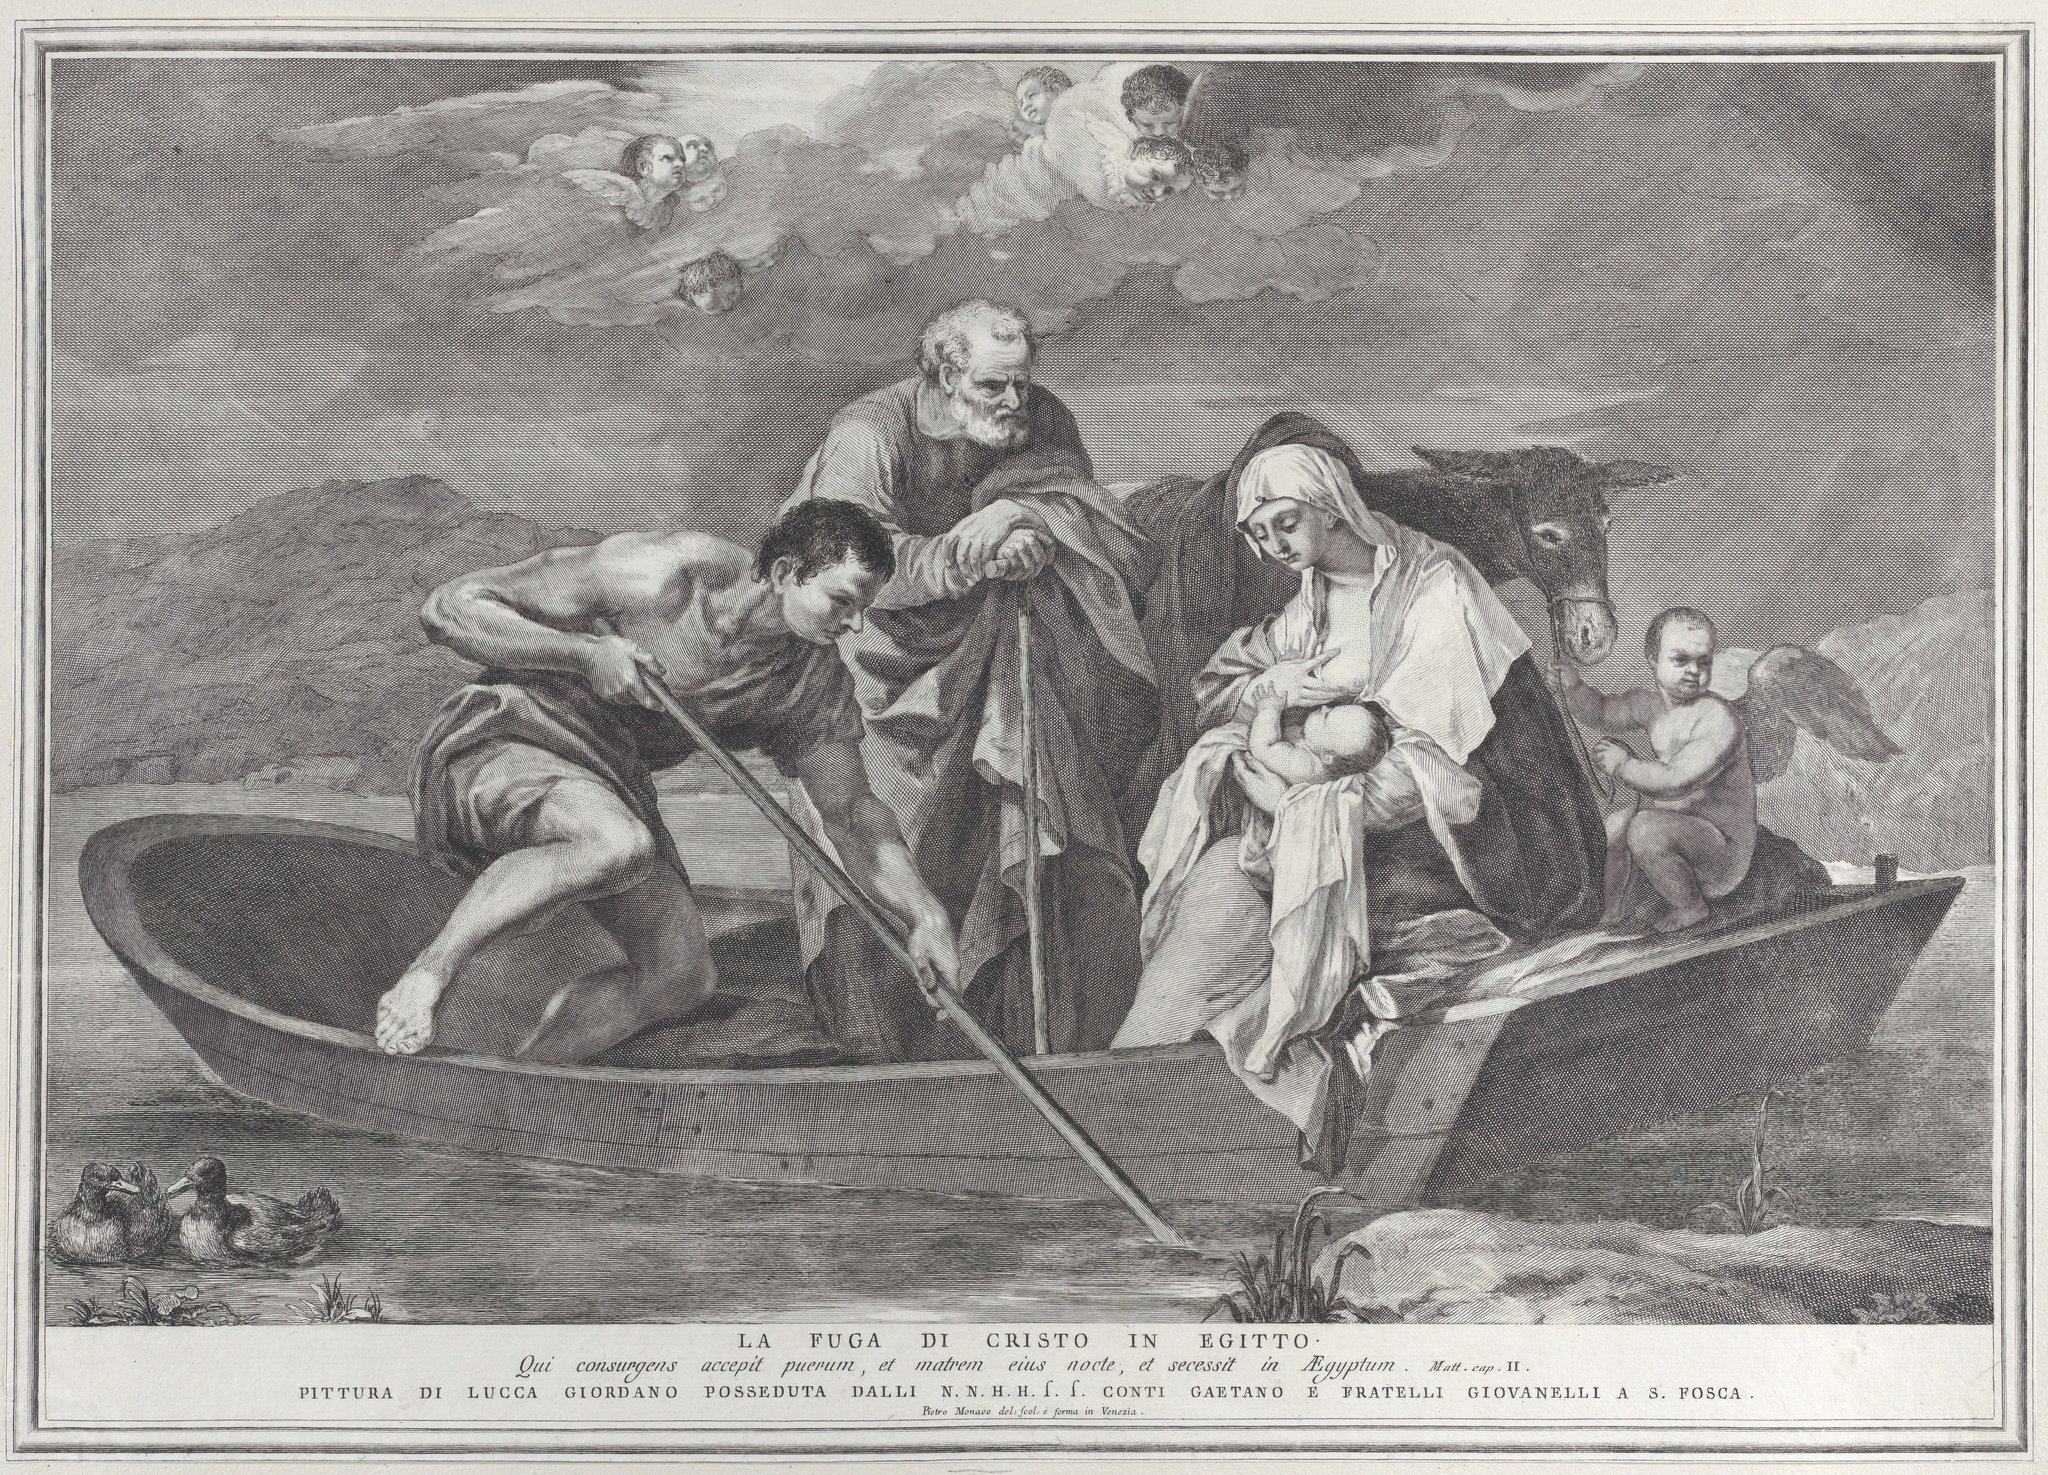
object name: print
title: The flight into Egypt, with the Holy Family in a boat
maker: pietro monaco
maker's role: artist and publisher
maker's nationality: italian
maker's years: 1707-1772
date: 1730-1750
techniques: engraving